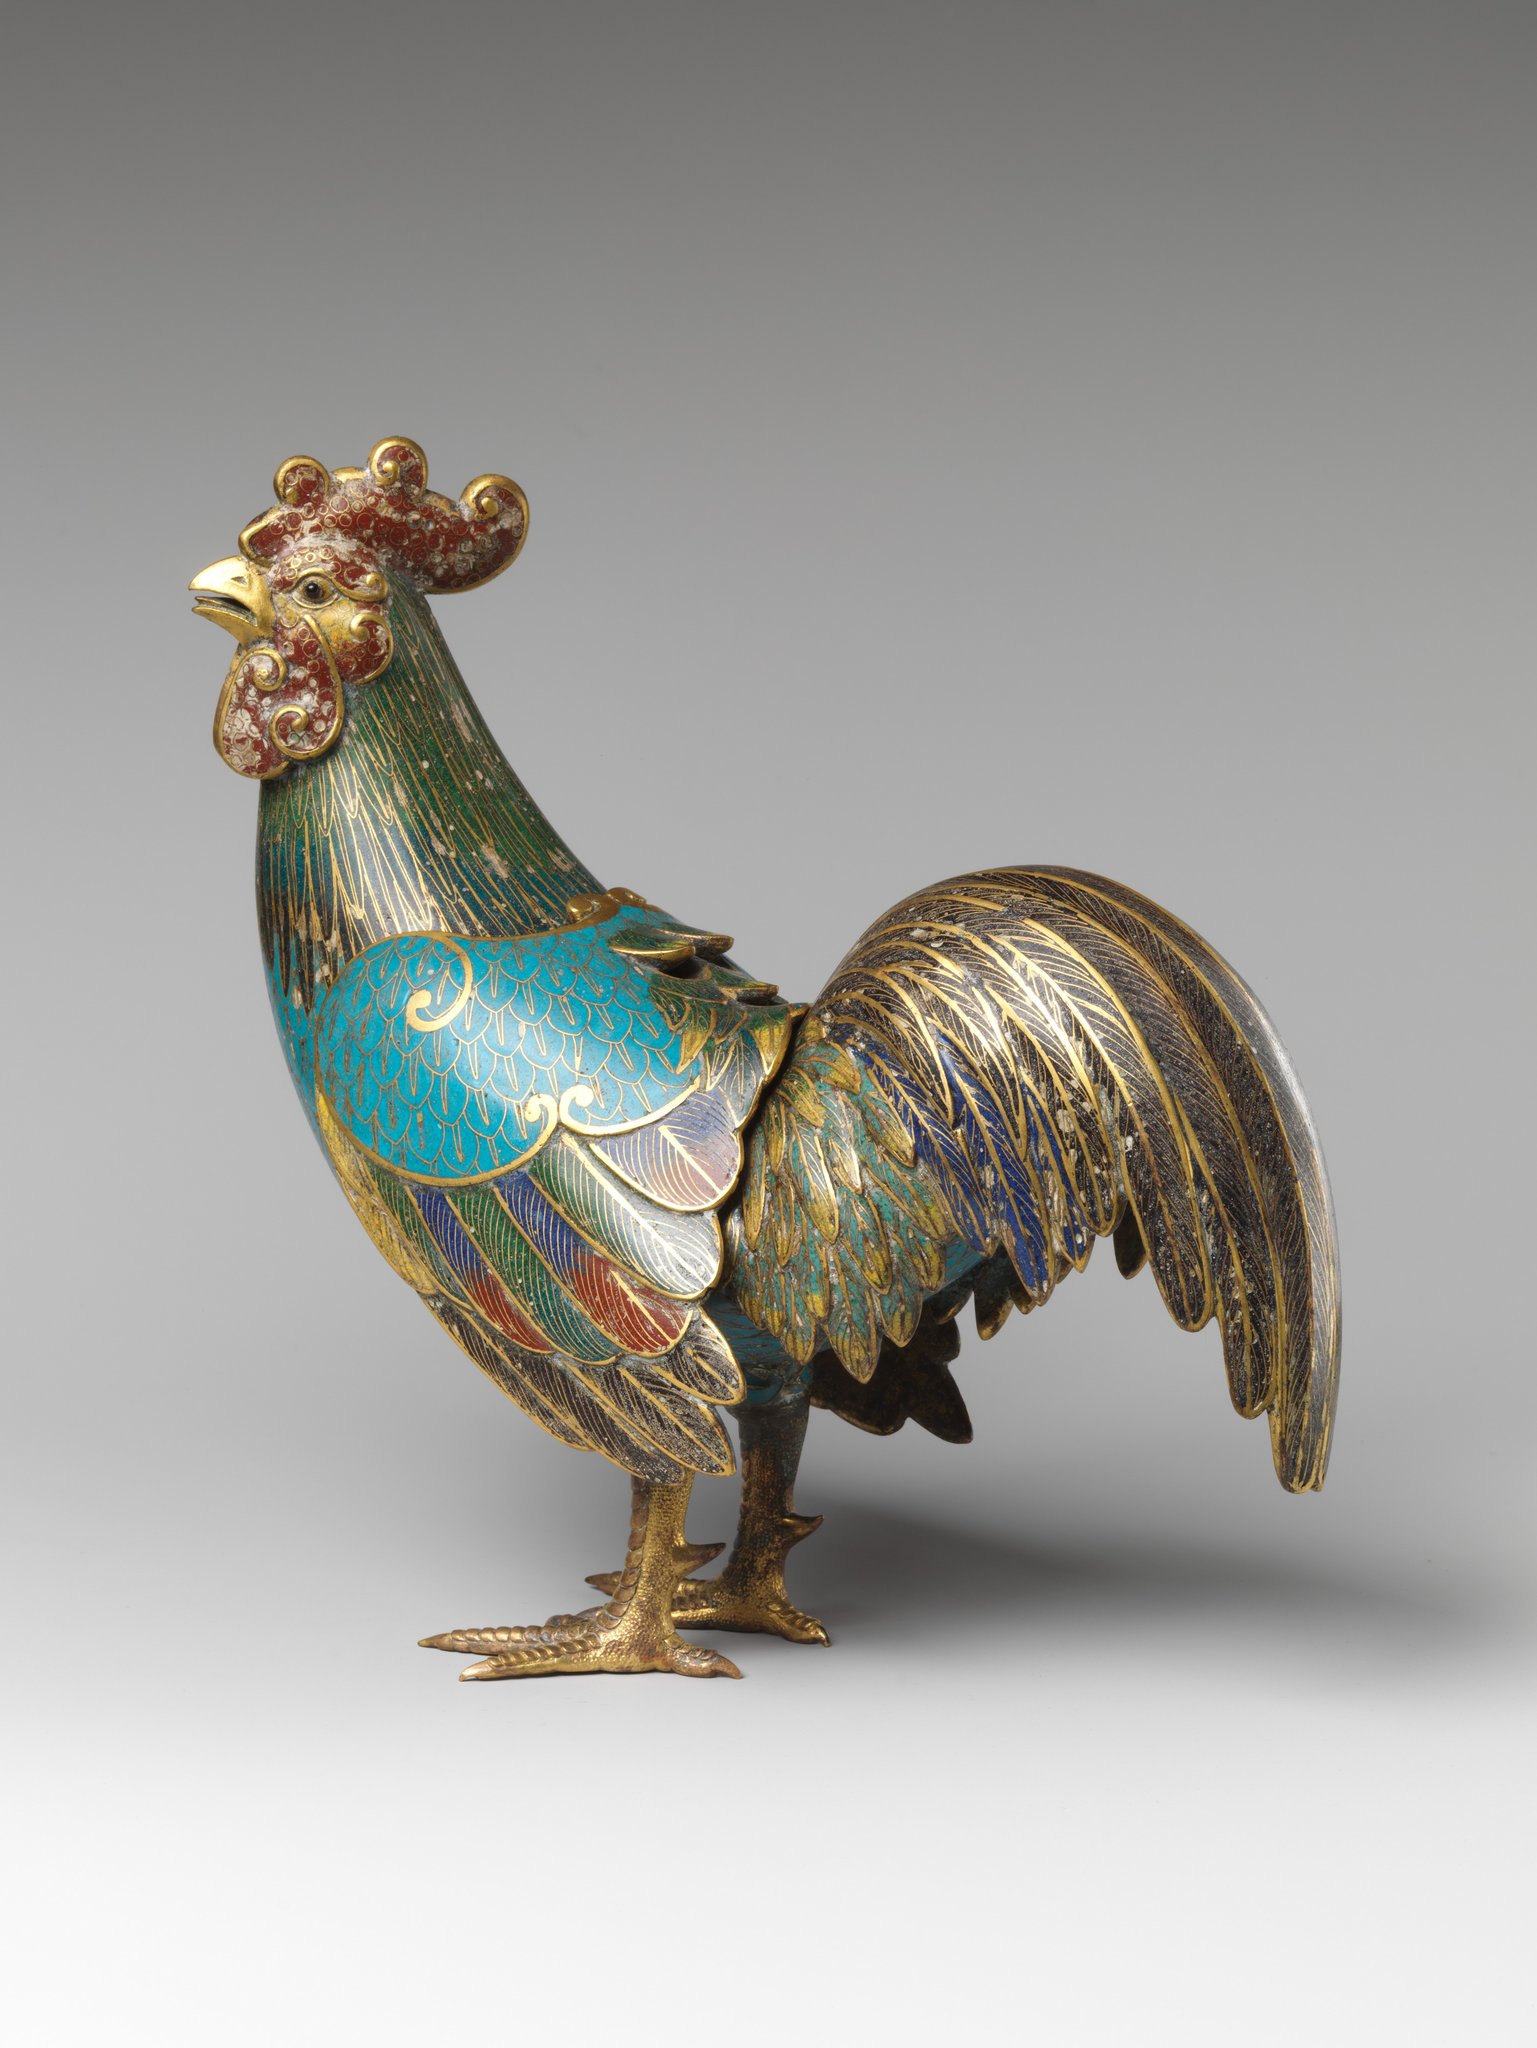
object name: incense burner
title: Incense burner in the shape of a rooster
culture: chinese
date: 1751-1800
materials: enamel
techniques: enamel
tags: roosters